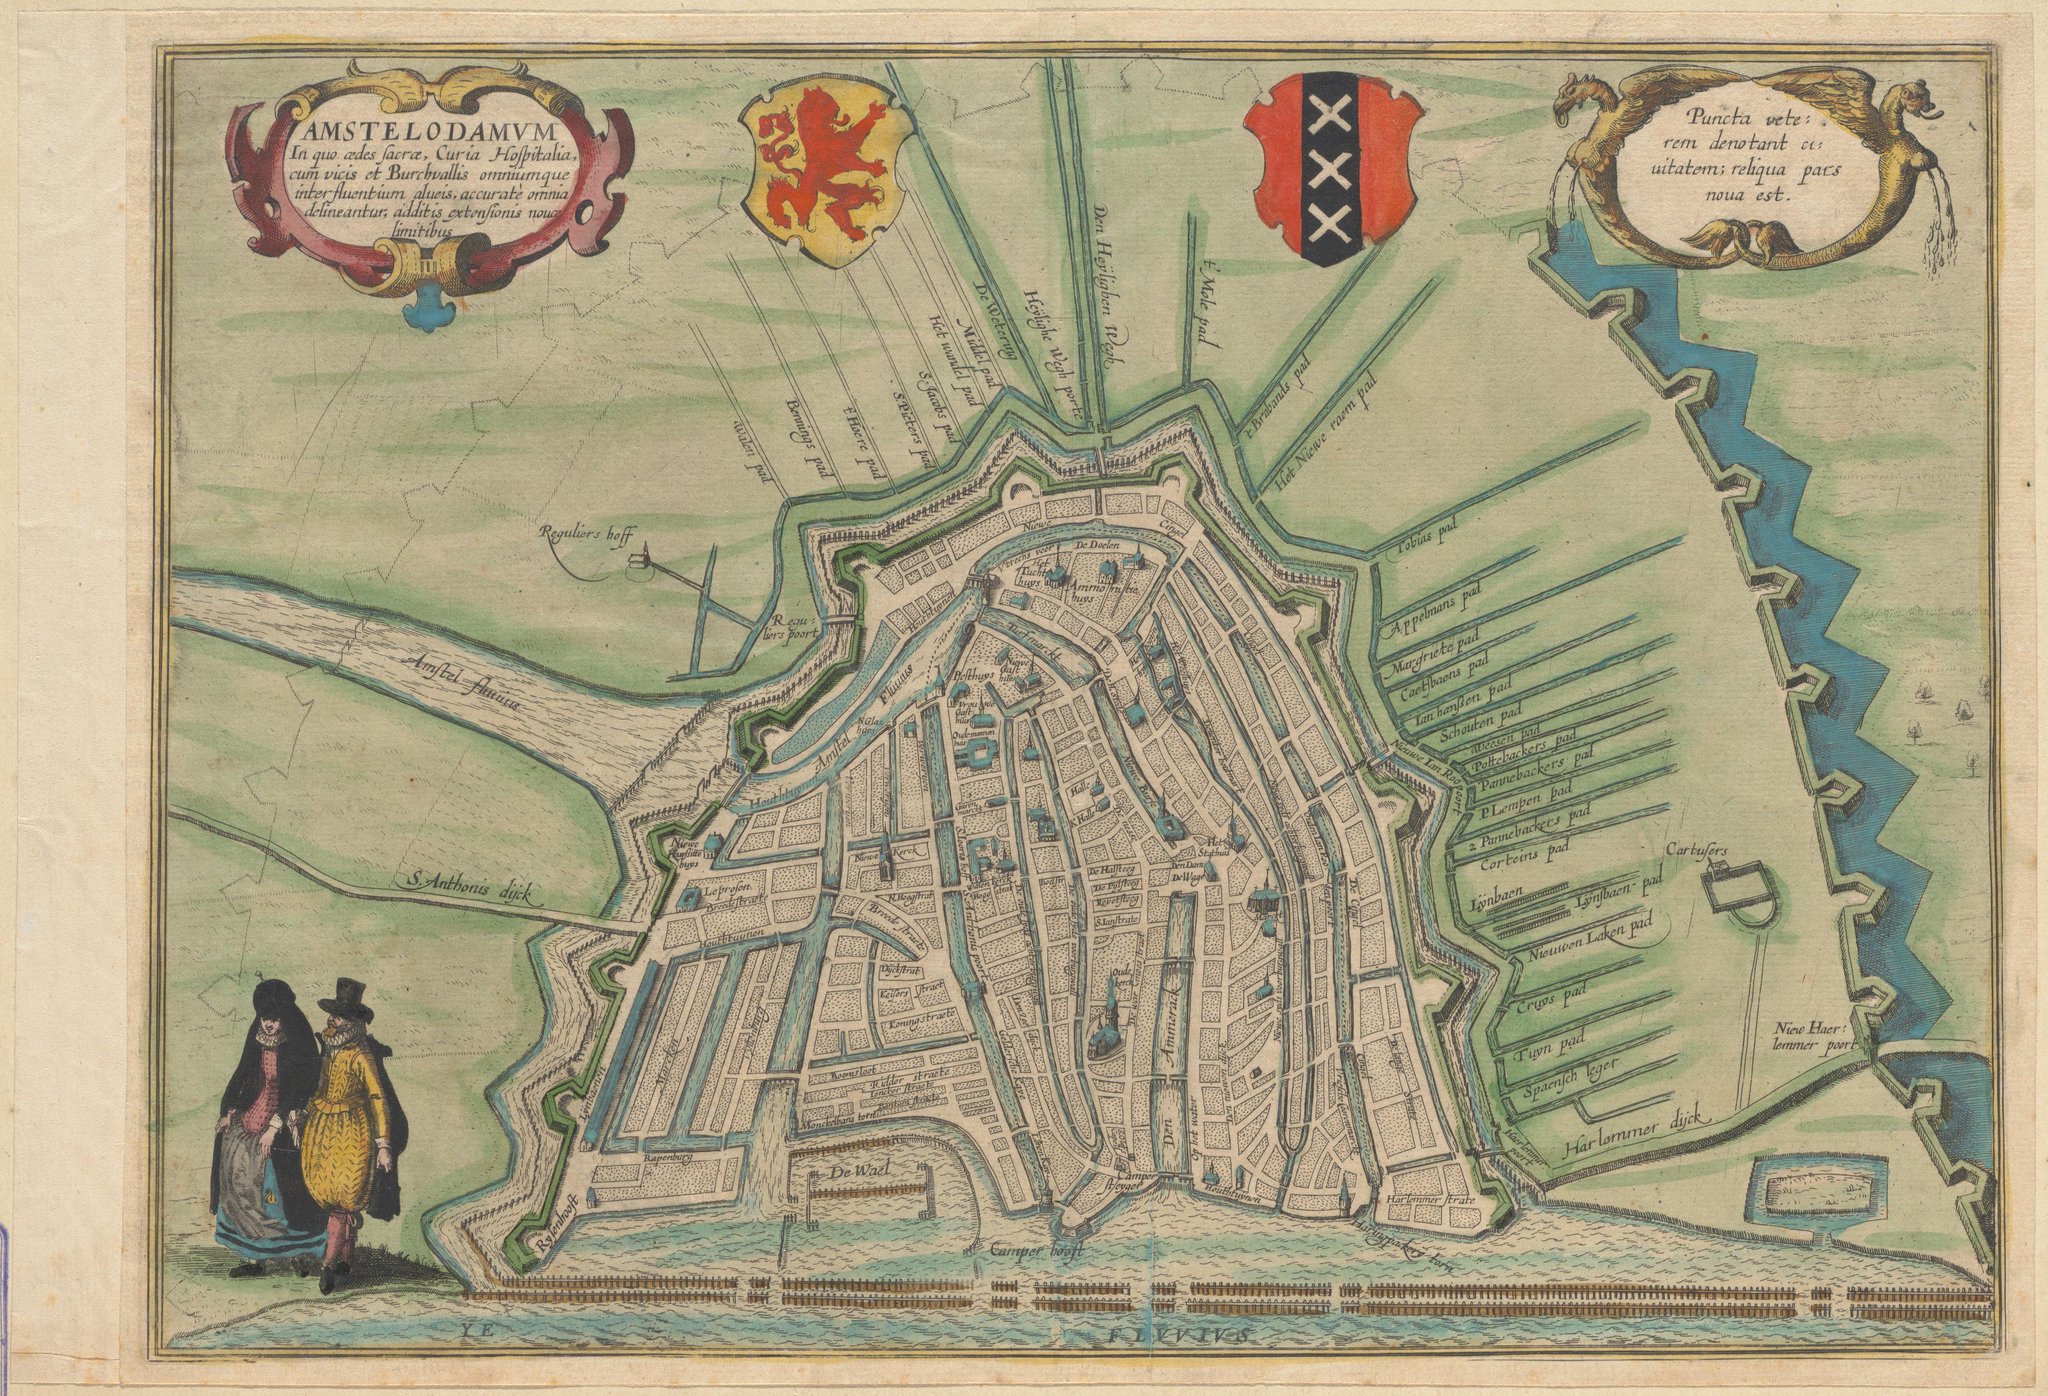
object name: area plan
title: Plattegrond van Amsterdam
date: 1618-1619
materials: ink, paper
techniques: engraving, etching, hand coloring, letterpress printing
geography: cologne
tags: coat of arms (as symbol of the state, etc.) (+ city; municipal), maps of cities, clothes, costume, coat of arms (as symbol of the state, etc.) (+ province; provincial), amsterdam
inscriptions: collector's mark: Lugt 1641b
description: Prent uit: Braun, Georg, en Abraham Hogenberg. Theatri Praecipuarum Totius Mundi Urbium (...). Keulen: s.n., 1617-1618, dl. 6.